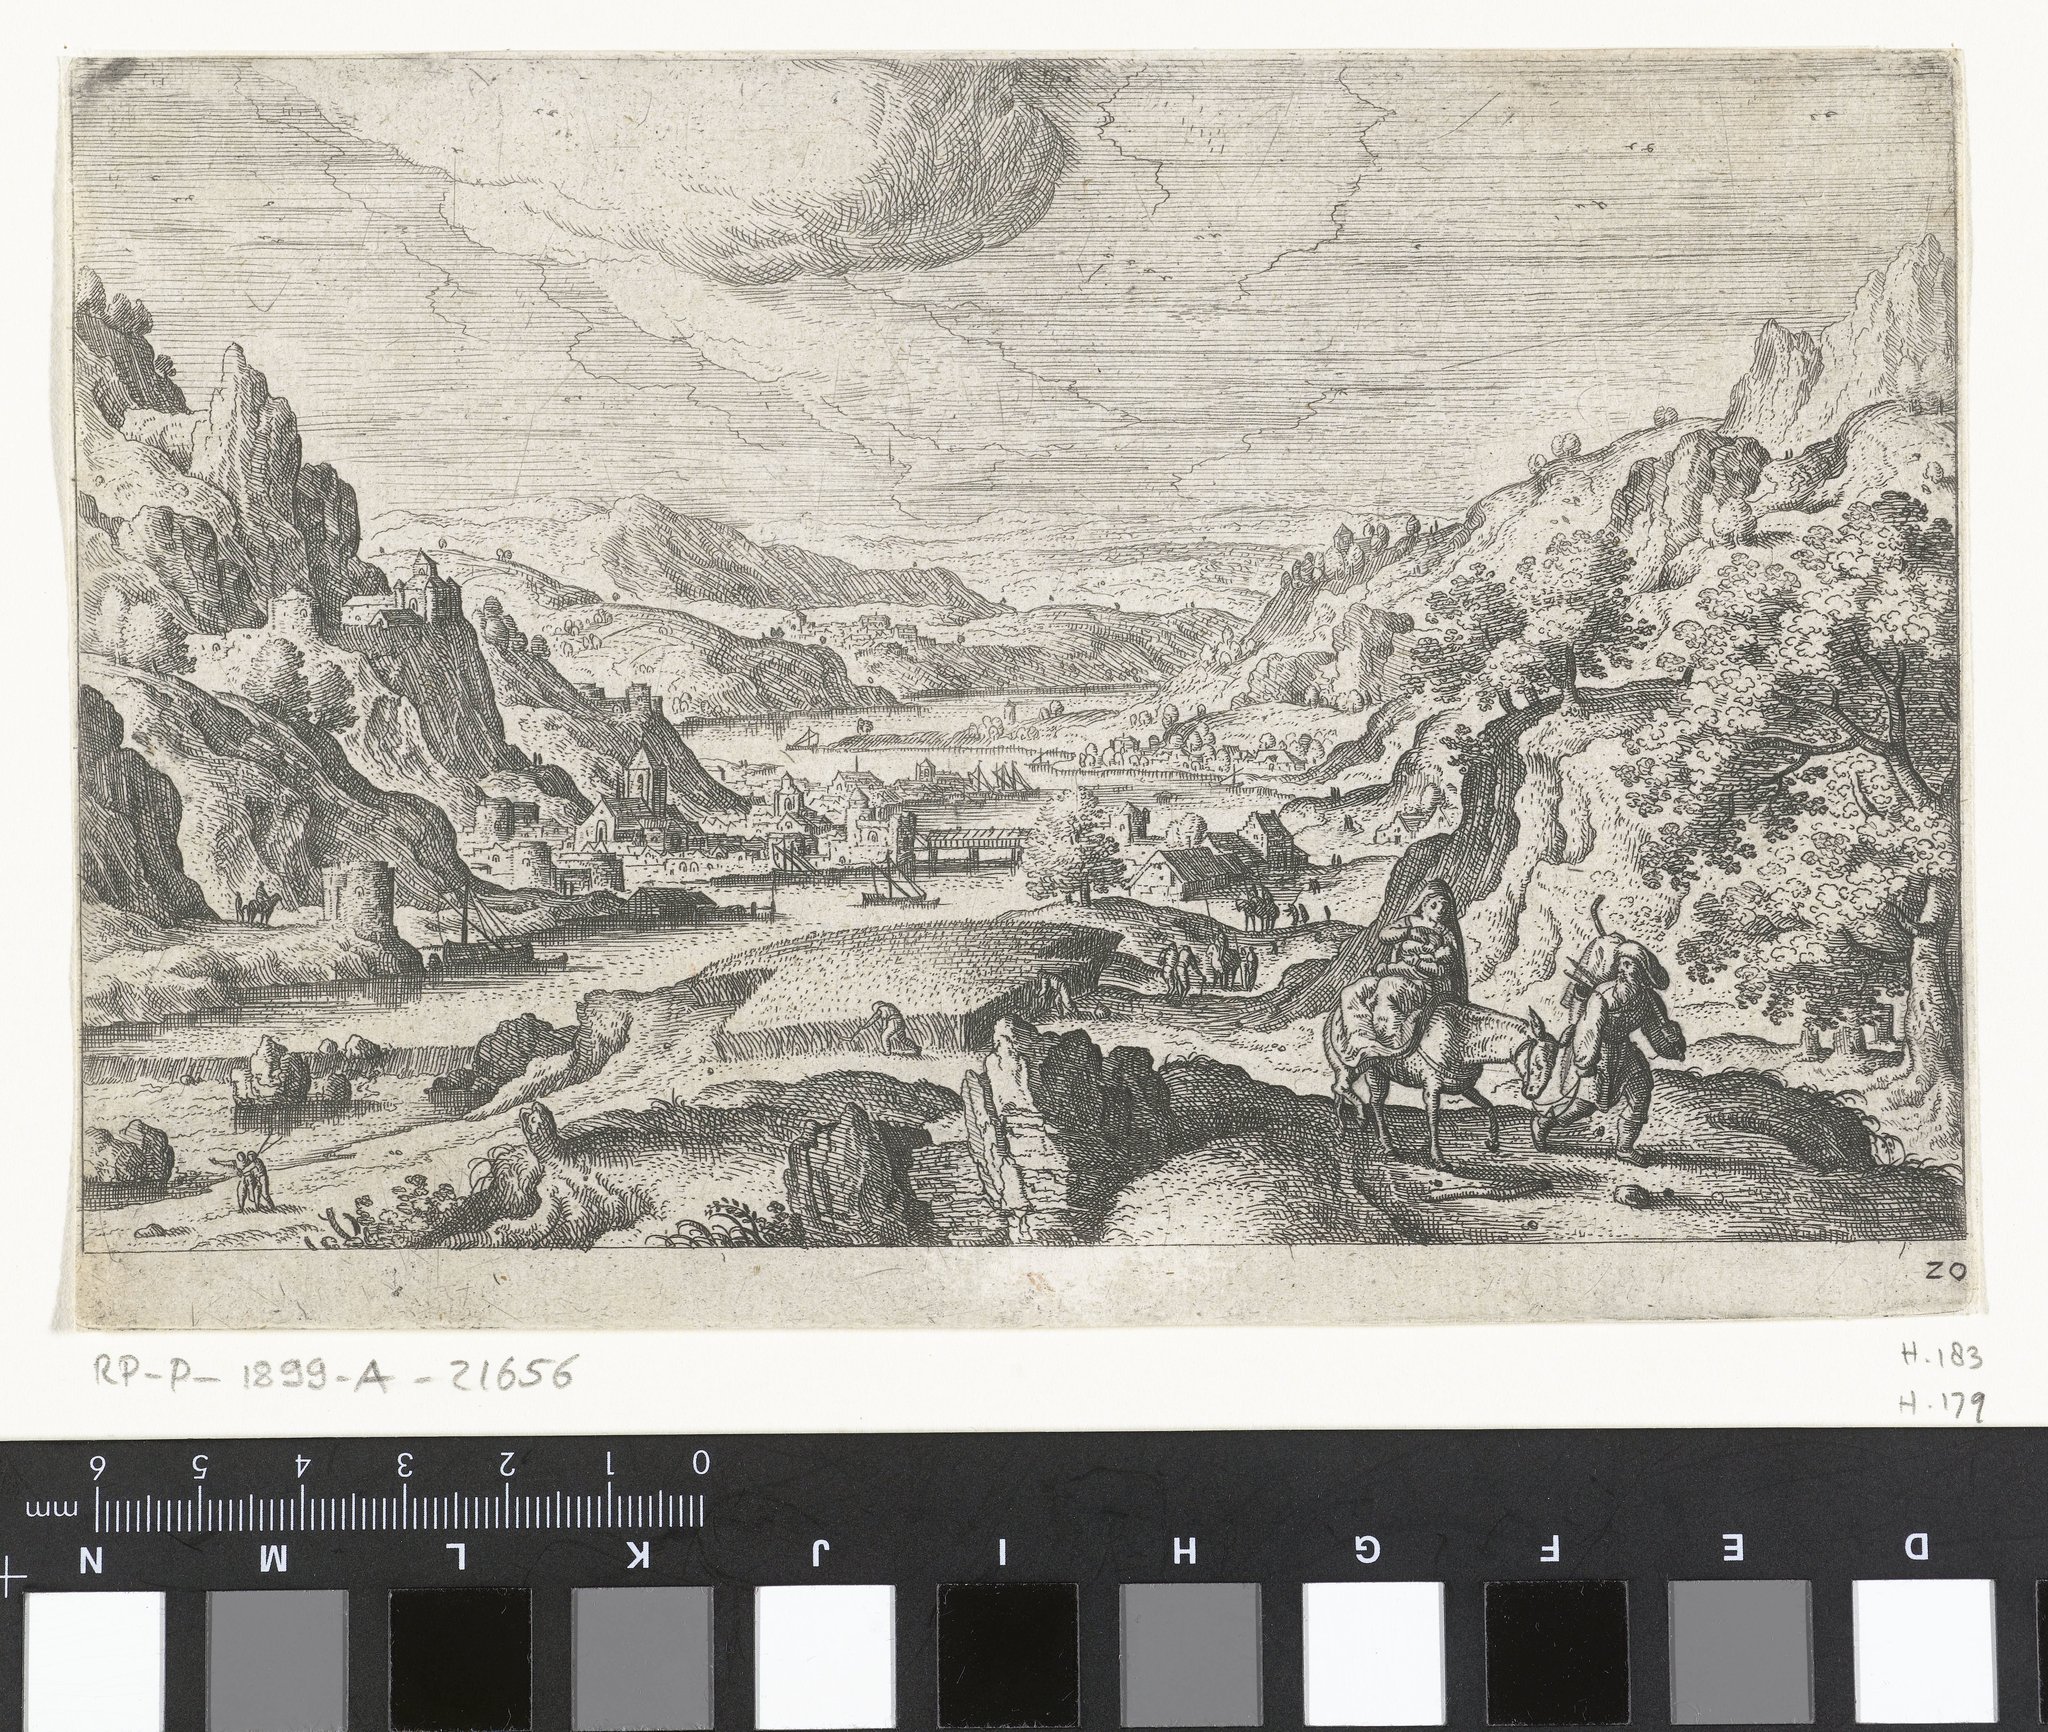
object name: print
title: Vlucht naar Egypte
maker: Anonymous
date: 1550-1650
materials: paper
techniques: etching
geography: southern netherlands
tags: the flight into egypt: mary, joseph, the child (and sometimes others) on their way; mary usually riding on an ass, soldiers of herod questioning the farmer, who is cutting the ripe wheat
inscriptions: collector's mark: Lugt 2228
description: Maria, Jozef en het Kind vluchten naar Egypte. Maria zit met het Christuskind op haar schoot op een ezel. Op de achtergrond is een graanveld te zien. Terwijl de boeren aan het oogsten zijn komen soldaten van Herodes en vragen naar de vluchtende familie.